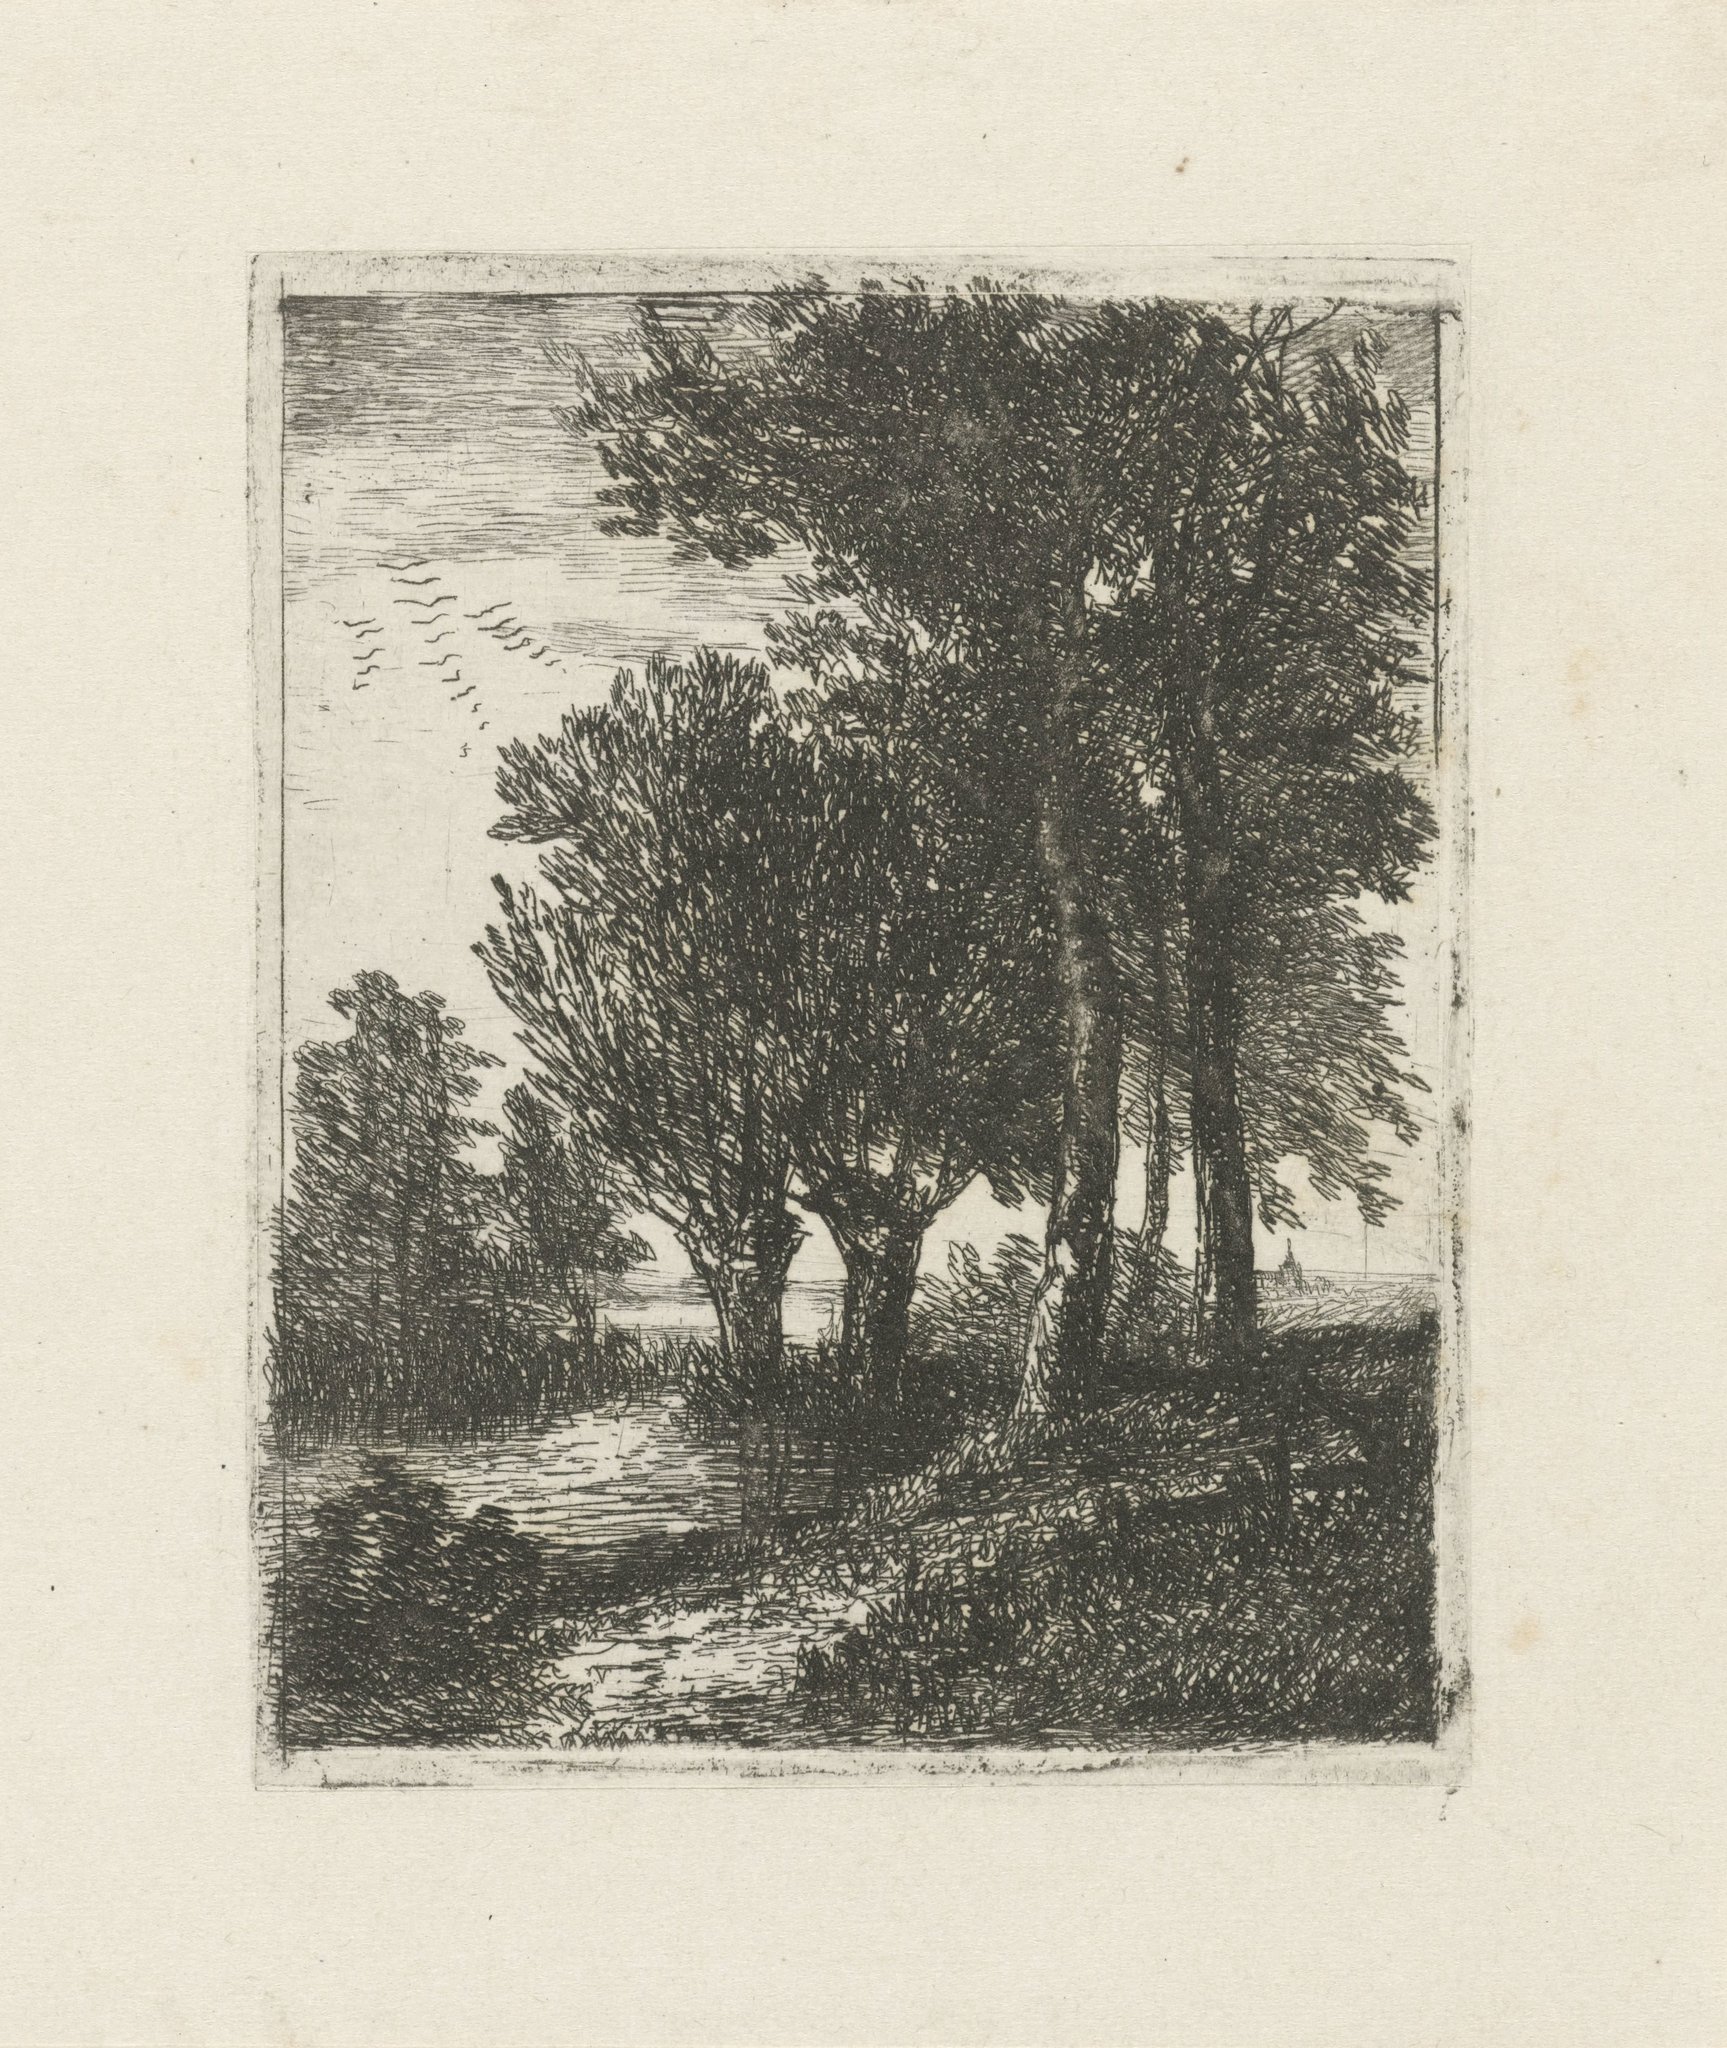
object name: print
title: Vijf bomen aan de waterkant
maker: hermanus jan hendrik van rijkelijkhuysen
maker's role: painter, print maker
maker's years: 1813-1883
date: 1823-1883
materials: paper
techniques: drypoint, etching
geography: utrecht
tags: trees, church (exterior), pond, pool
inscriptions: collector's mark: Lugt 2228, collector's mark: Lugt 1485